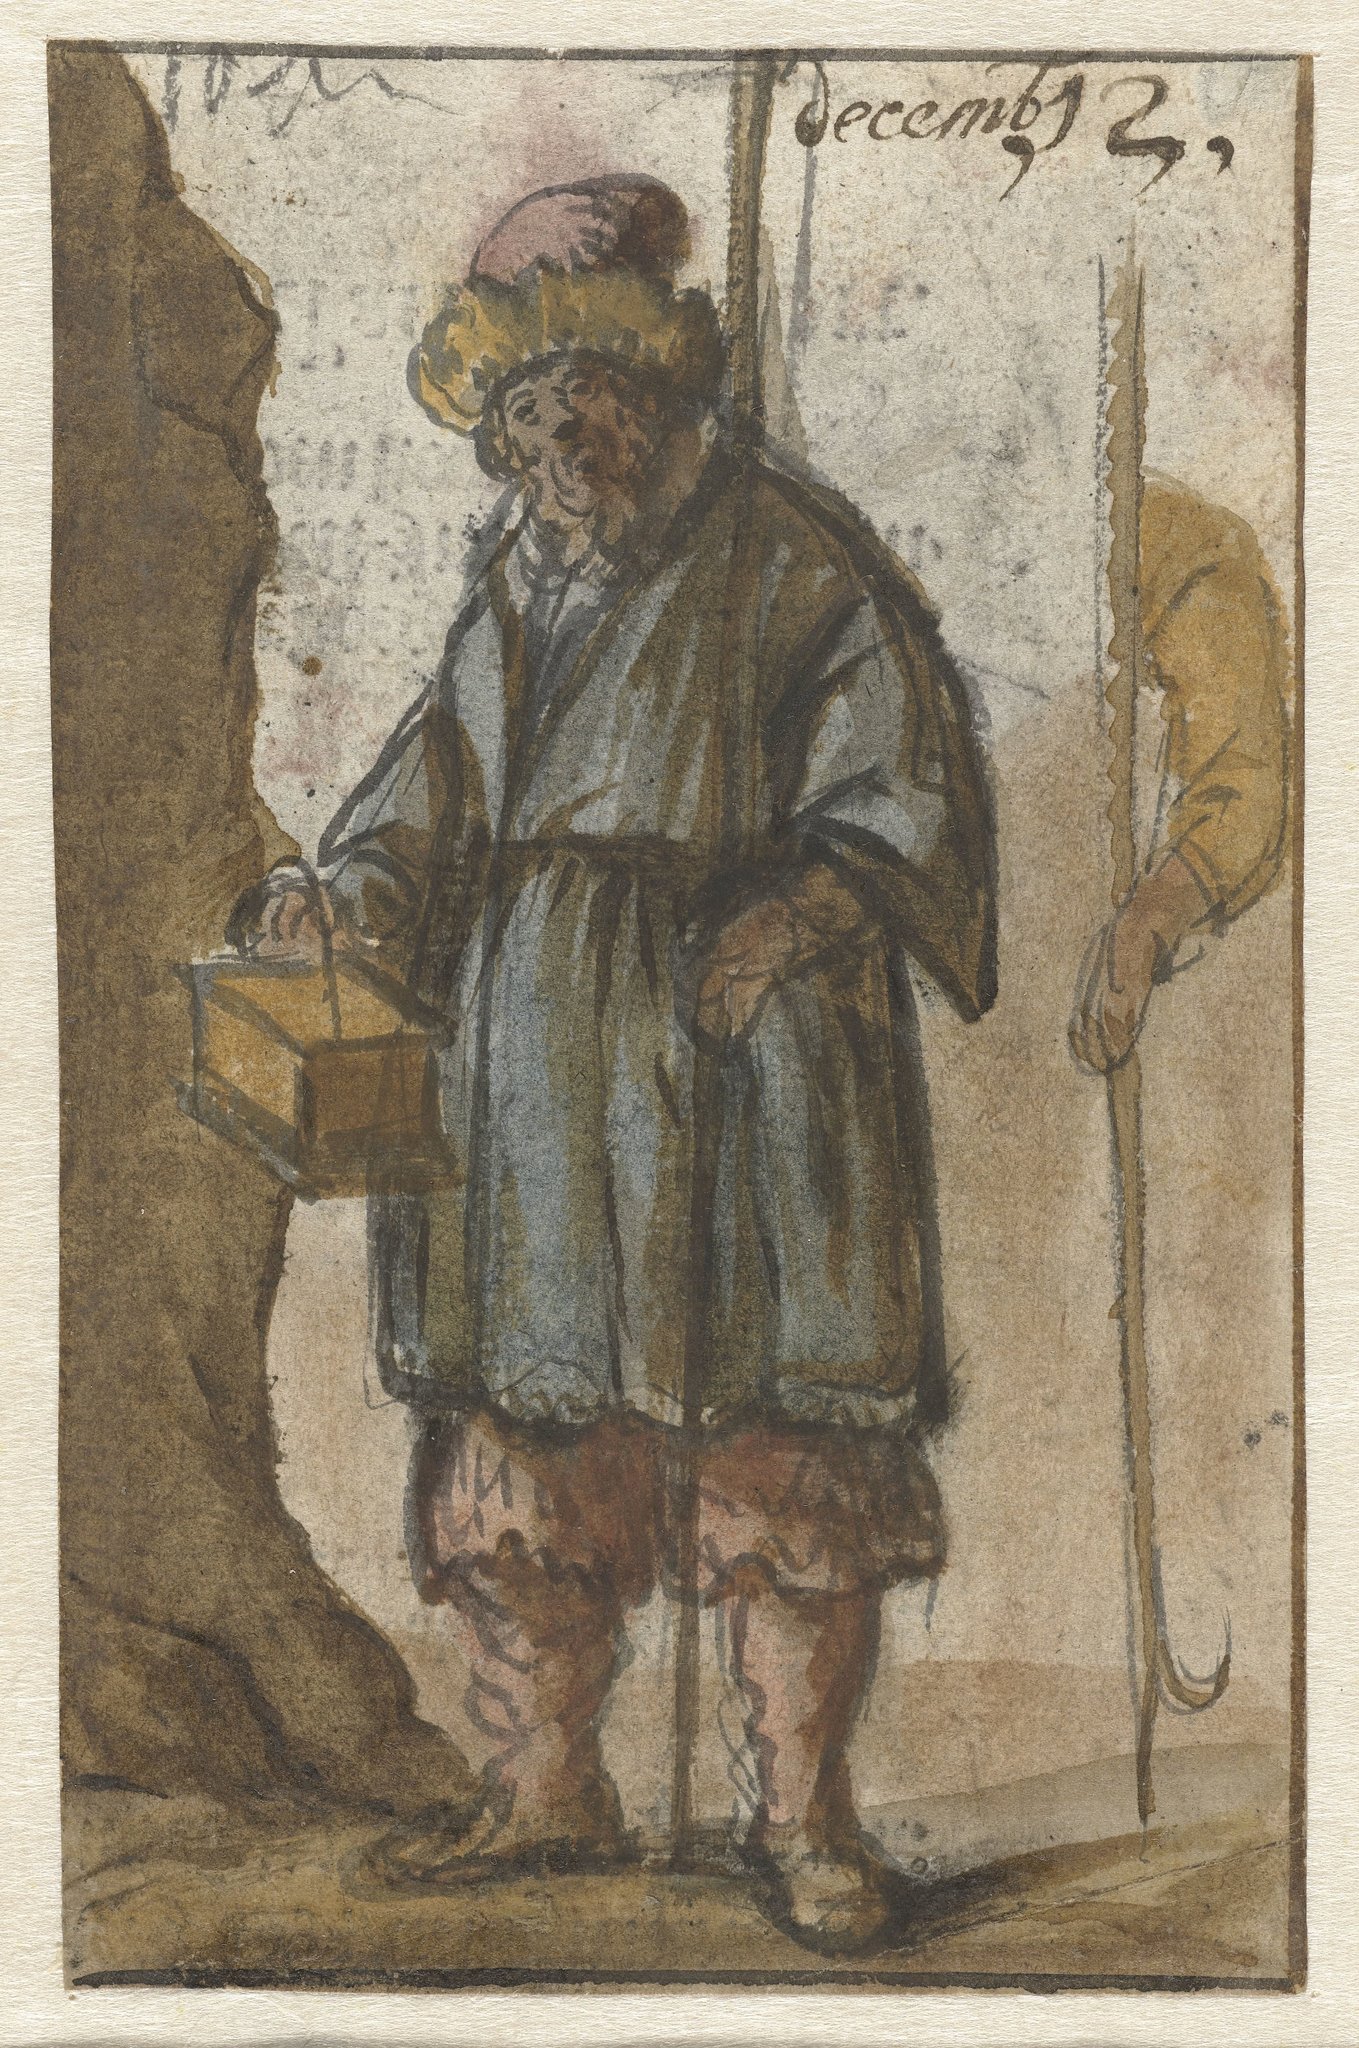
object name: drawing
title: De twaalf maanden van het jaar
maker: Anonymous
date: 1600-1699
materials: paper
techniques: brush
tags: foot-stove, december and its 'labours'